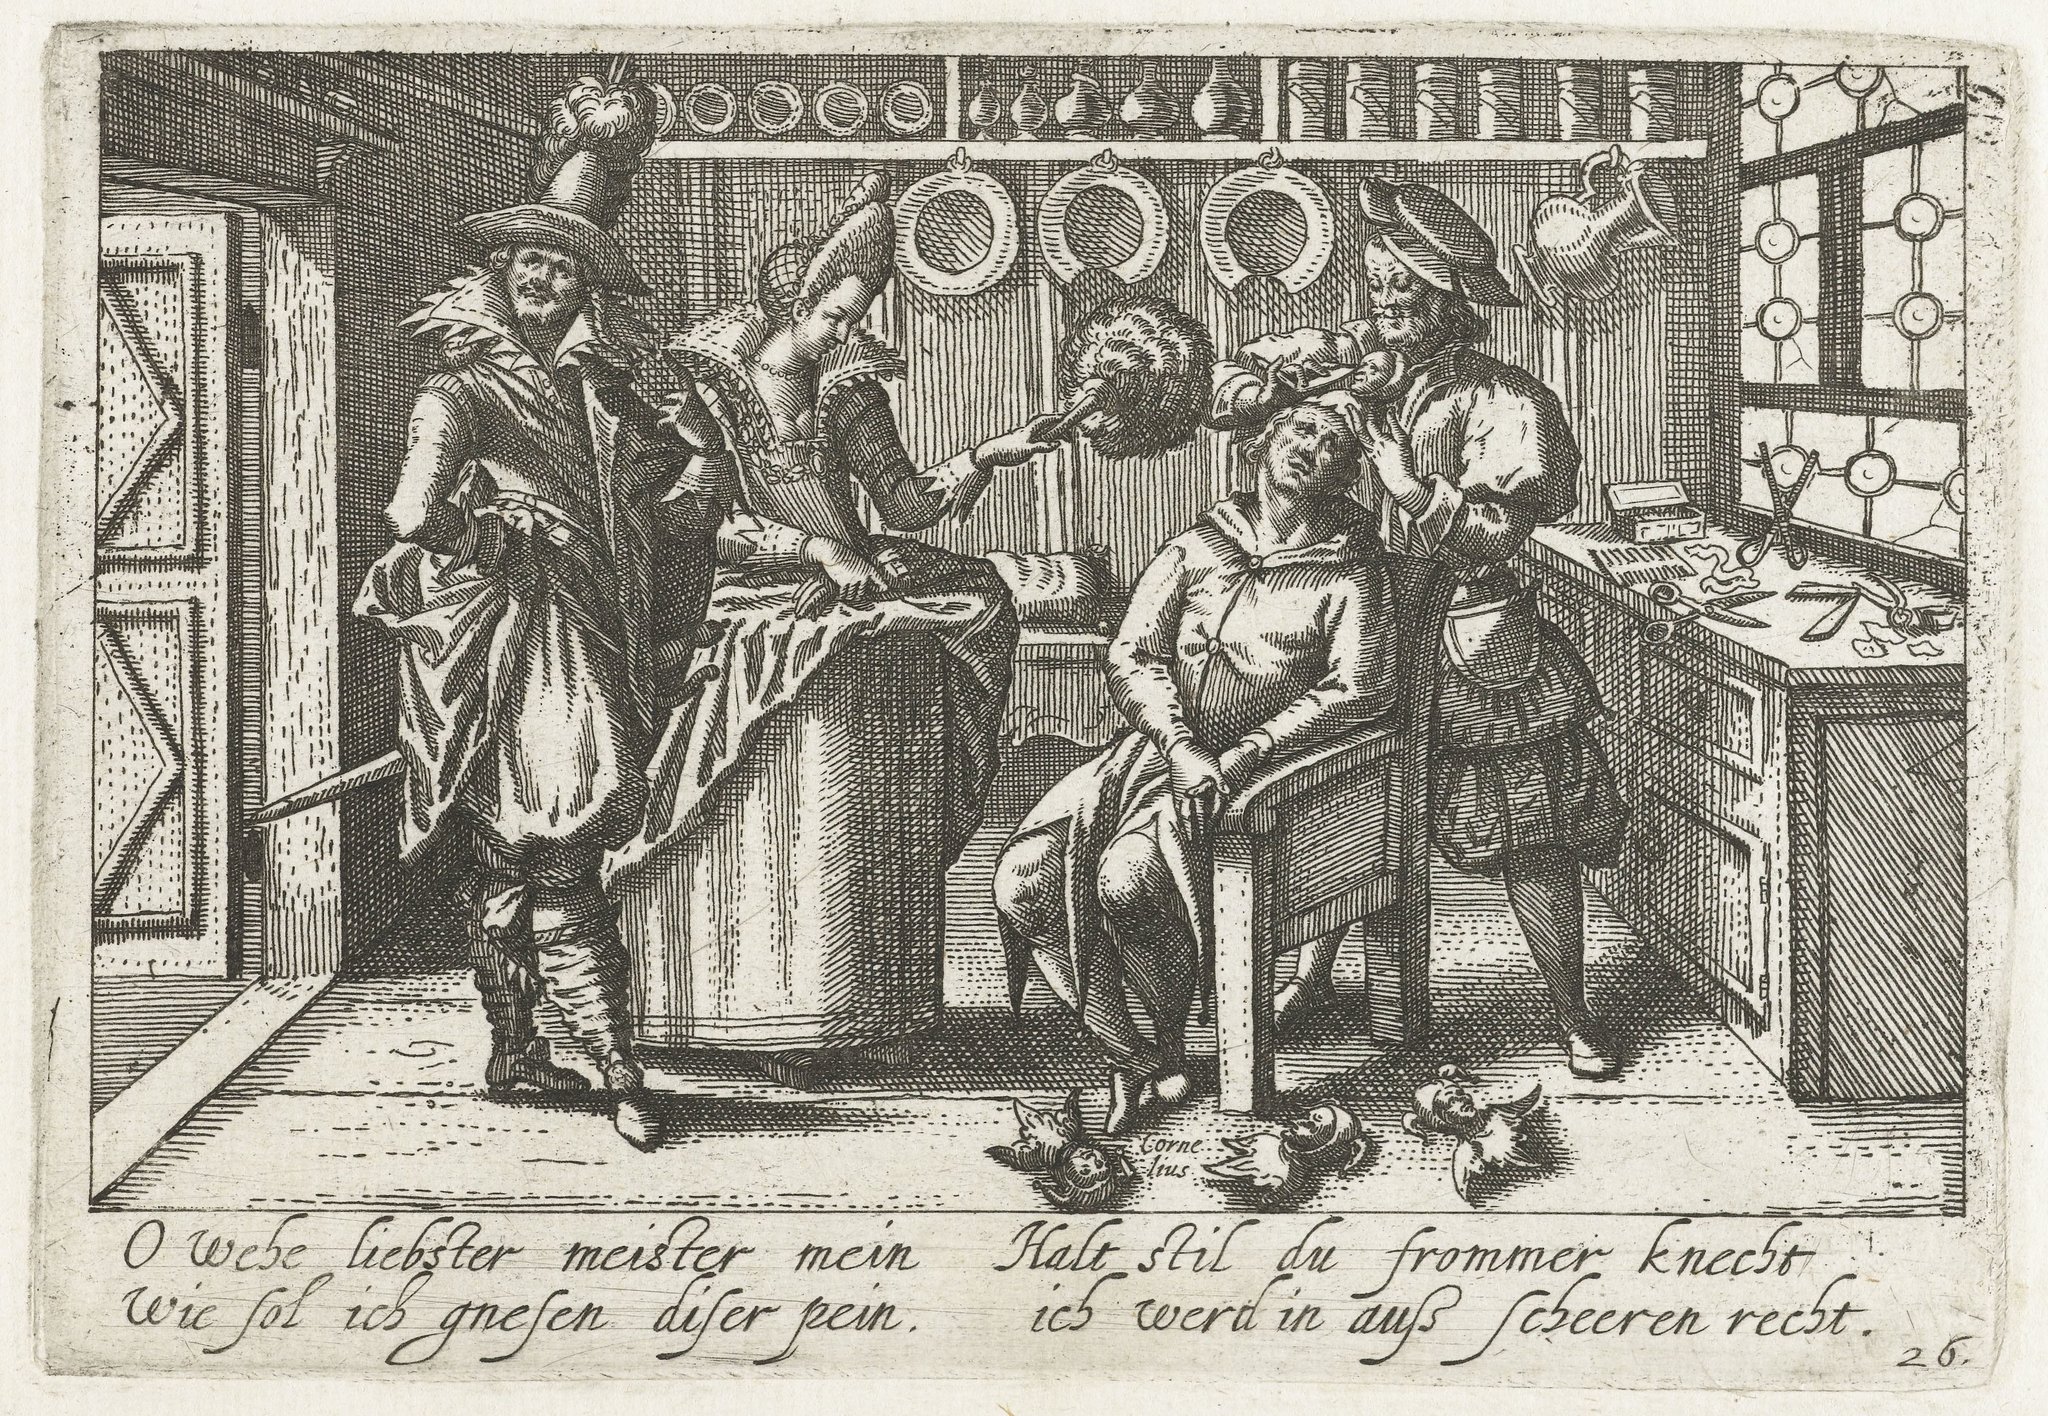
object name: print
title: Dwaze man wordt door de barbier ontdaan van de nar die uit zijn hoofd groeit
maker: jacob van der heyden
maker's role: draughtsman, print maker, publisher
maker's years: 1573-1645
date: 1608-1618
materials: paper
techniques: engraving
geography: straatsburg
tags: 'album amicorum', 'stammbuch', shaving (pretending to cure simpletons), fool, simpleton, numskull, morality, shaving, being shaved, barber, barbershop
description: Deze serie, getiteld ‘Pugillus facetiarum iconographicarum in studiosorum (…)’, bestond vermoedelijk uit 36 of meer prenten. Van deze serie zijn in ieder geval twee uitgaven bekend, uit 1608 en 1618. De prenten uit deze serie in de collectie van het Rijksmuseum (RP-P-1996-1 t/m RP-P-1996-36) zijn vermoedelijk afkomstig uit verschillende uitgaven, of uit de tweede uitgave. De inhoud van beide uitgaven verschilt, maar om de precieze inhoud van de verschillende uitgaven vast te stellen is meer onderzoek nodig. Er zijn geen volledige exemplaren van de eerste uitgave bekend. Aan de hand van de analyse van een andere serie, ‘Jeucht spieghel’,* die kopieën van ‘Pugillus’ bevat en is uitgegeven in 1610 én de aanwezige exemplaren van prenten uit ‘Pugillus’ in een inmiddels verloren album amicorum uit 1610,** kan in ieder geval van een aantal prenten gesteld worden dat ze al voorkwamen in de uitgave van 1608. Dit geldt voor RP-P-1996-1 (de titelprent), RP-P-1996-5, RP-P-1996-6, RP-P-1996-7, RP-P-1996-8, RP-P-1996-9, RP-P-1996-10, RP-P-1996-11, RP-P-1996-12, RP-P-1996-13, RP-P-1996-14, RP-P-1996-15, RP-P-1996-16, RP-P-1996-17, RP-P-1996-18, RP-P-1996-19, RP-P-1996-24, RP-P-1996-28, RP-P-1996-29, RP-P-1996-33 en RP-P-1996-35. Van één prent (RP-P-1996-31) kan vastgesteld worden dat die pas in de latere uitgave van 1618 voorkwam, omdat het kopie is van een prent uit weer een andere serie, ‘Academia sive speculum vitae scholasticae (…)’, die werd uitgegeven in 1612.*** Van de huidige prent is onduidelijk of hij al voorkwam in de uitgave van 1608. * Z.G.H.P.H.S [Zacharias Heyns]. Jeucht spieghel. S.l.s.n., 1610. Voor een gedigitaliseerd exemplaar zie: https://archive.org/details/ned-kbn-all-00000628-001/page/n9/mode/2up. ** Zie: Erman, Wilhelm en Ewald Horn. Bibliographie der deutschen Universitäten, systematisch geordnetes Verzeichnis der bis Ende 1899 gedruckten Bücher und Aufsätze über das deutsche Universitätswesen. Leipzig en Berlijn: Verlag von B.G. Teubner, 1904, dl. 1, p. 826-832, no. 17328. https://archive.org/details/bibliographieder01ermauoft/page/826/mode/2up *** Passe, Crispijn van de (I). Academia sive speculum vitae scholasticae (…). Arnhem: Johannes Janssonius [Jan Jansz.], 1612. Voor een gedigitaliseerd exemplaar zie: http://gallica.bnf.fr/ark:/12148/btv1b55005974h.